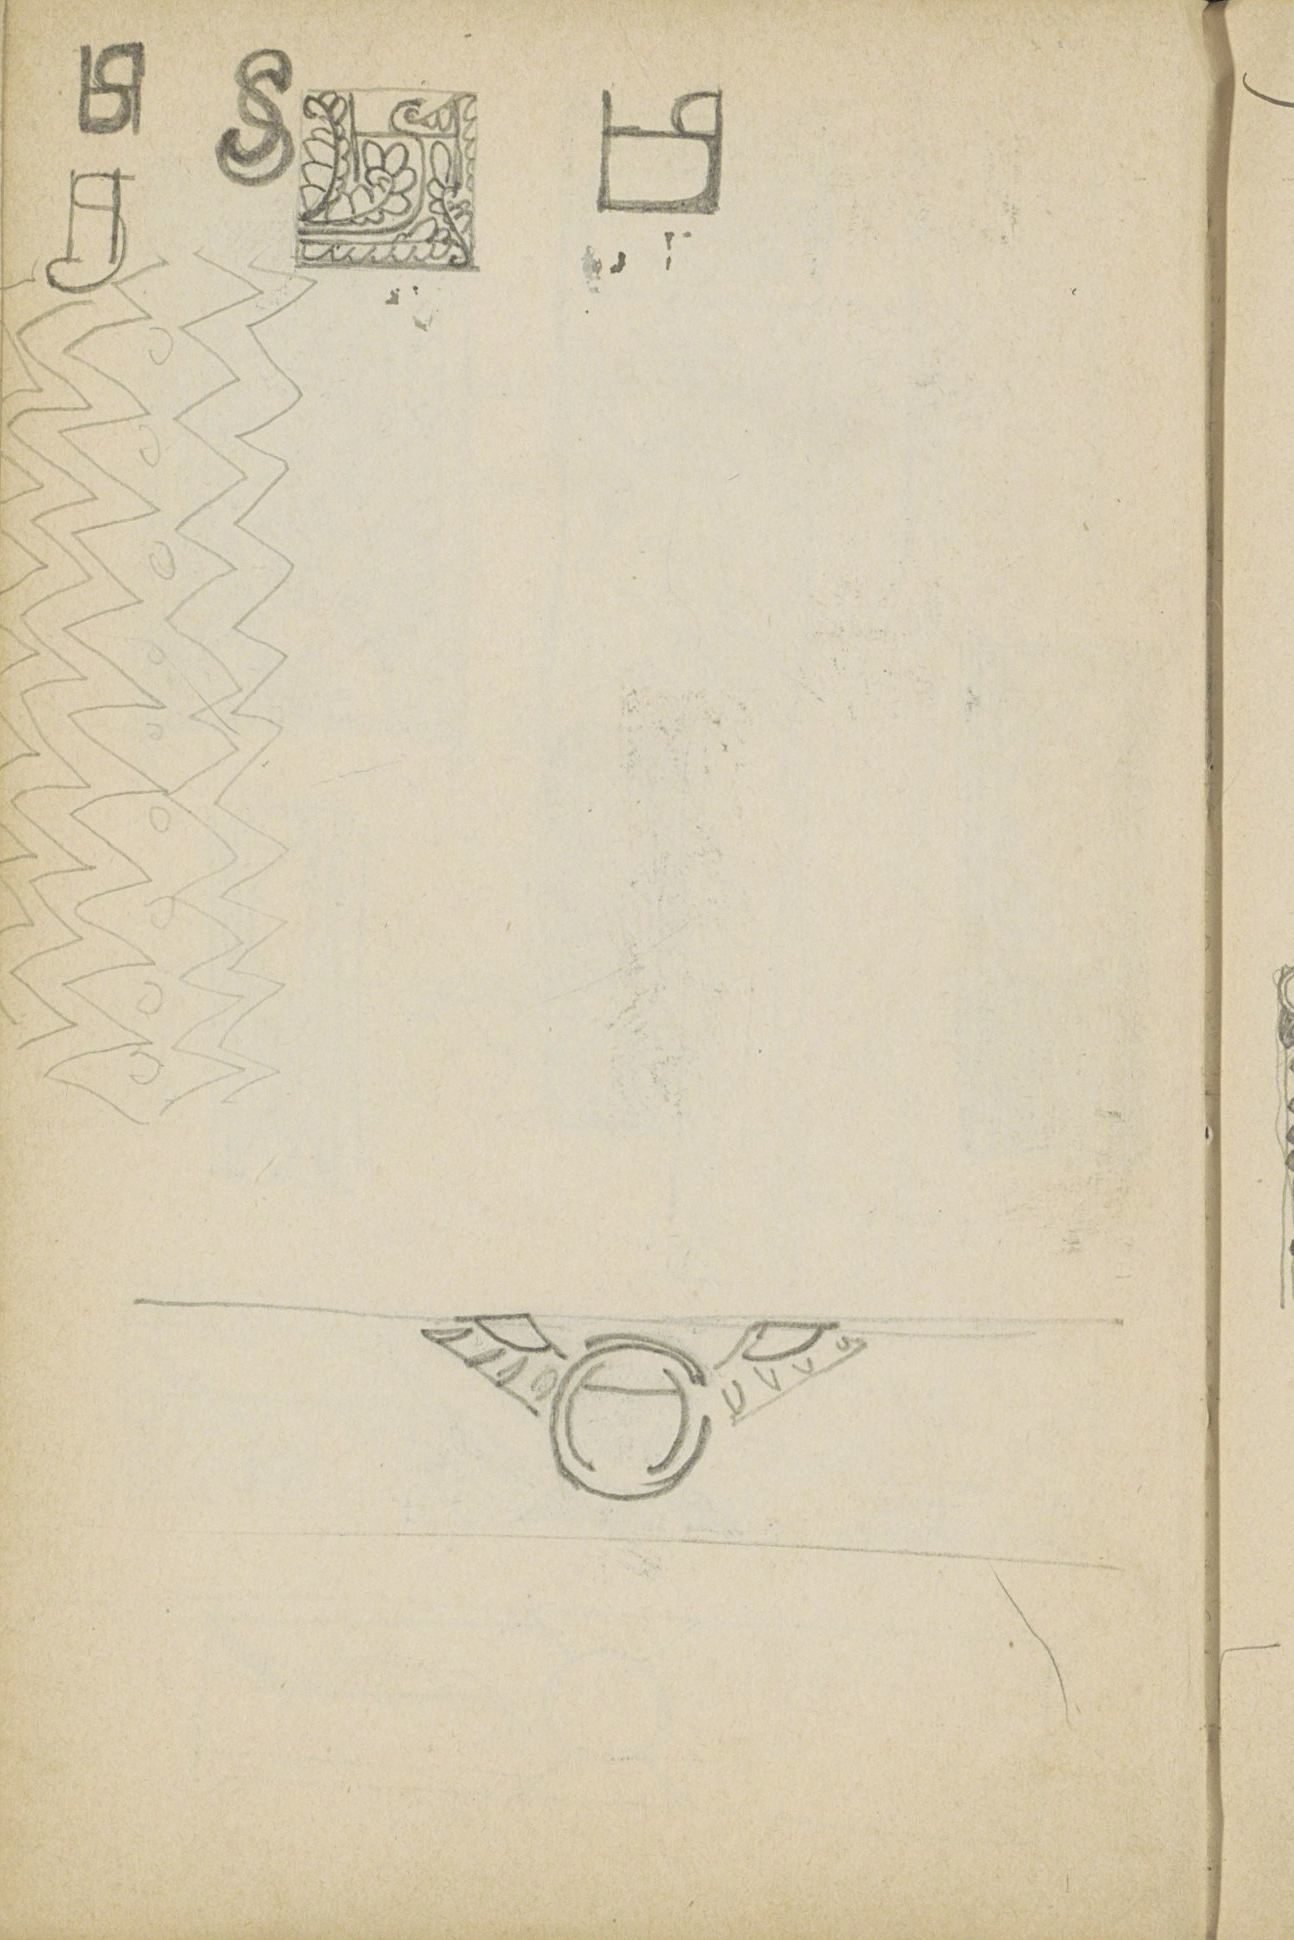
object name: sketchbook leaf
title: Ontwerpen voor een monogram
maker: reijer stolk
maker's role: draughtsman, print maker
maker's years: 1896-1945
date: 1908-1919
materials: paper, pencil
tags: ornaments ~ art, fancy letters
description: Combinaties van de letters 'R' en 'S', de initialen van de kunstenaar. Tevens een ornamentontwerp. Blad 11 verso uit een schetsboek met 33 bladen.